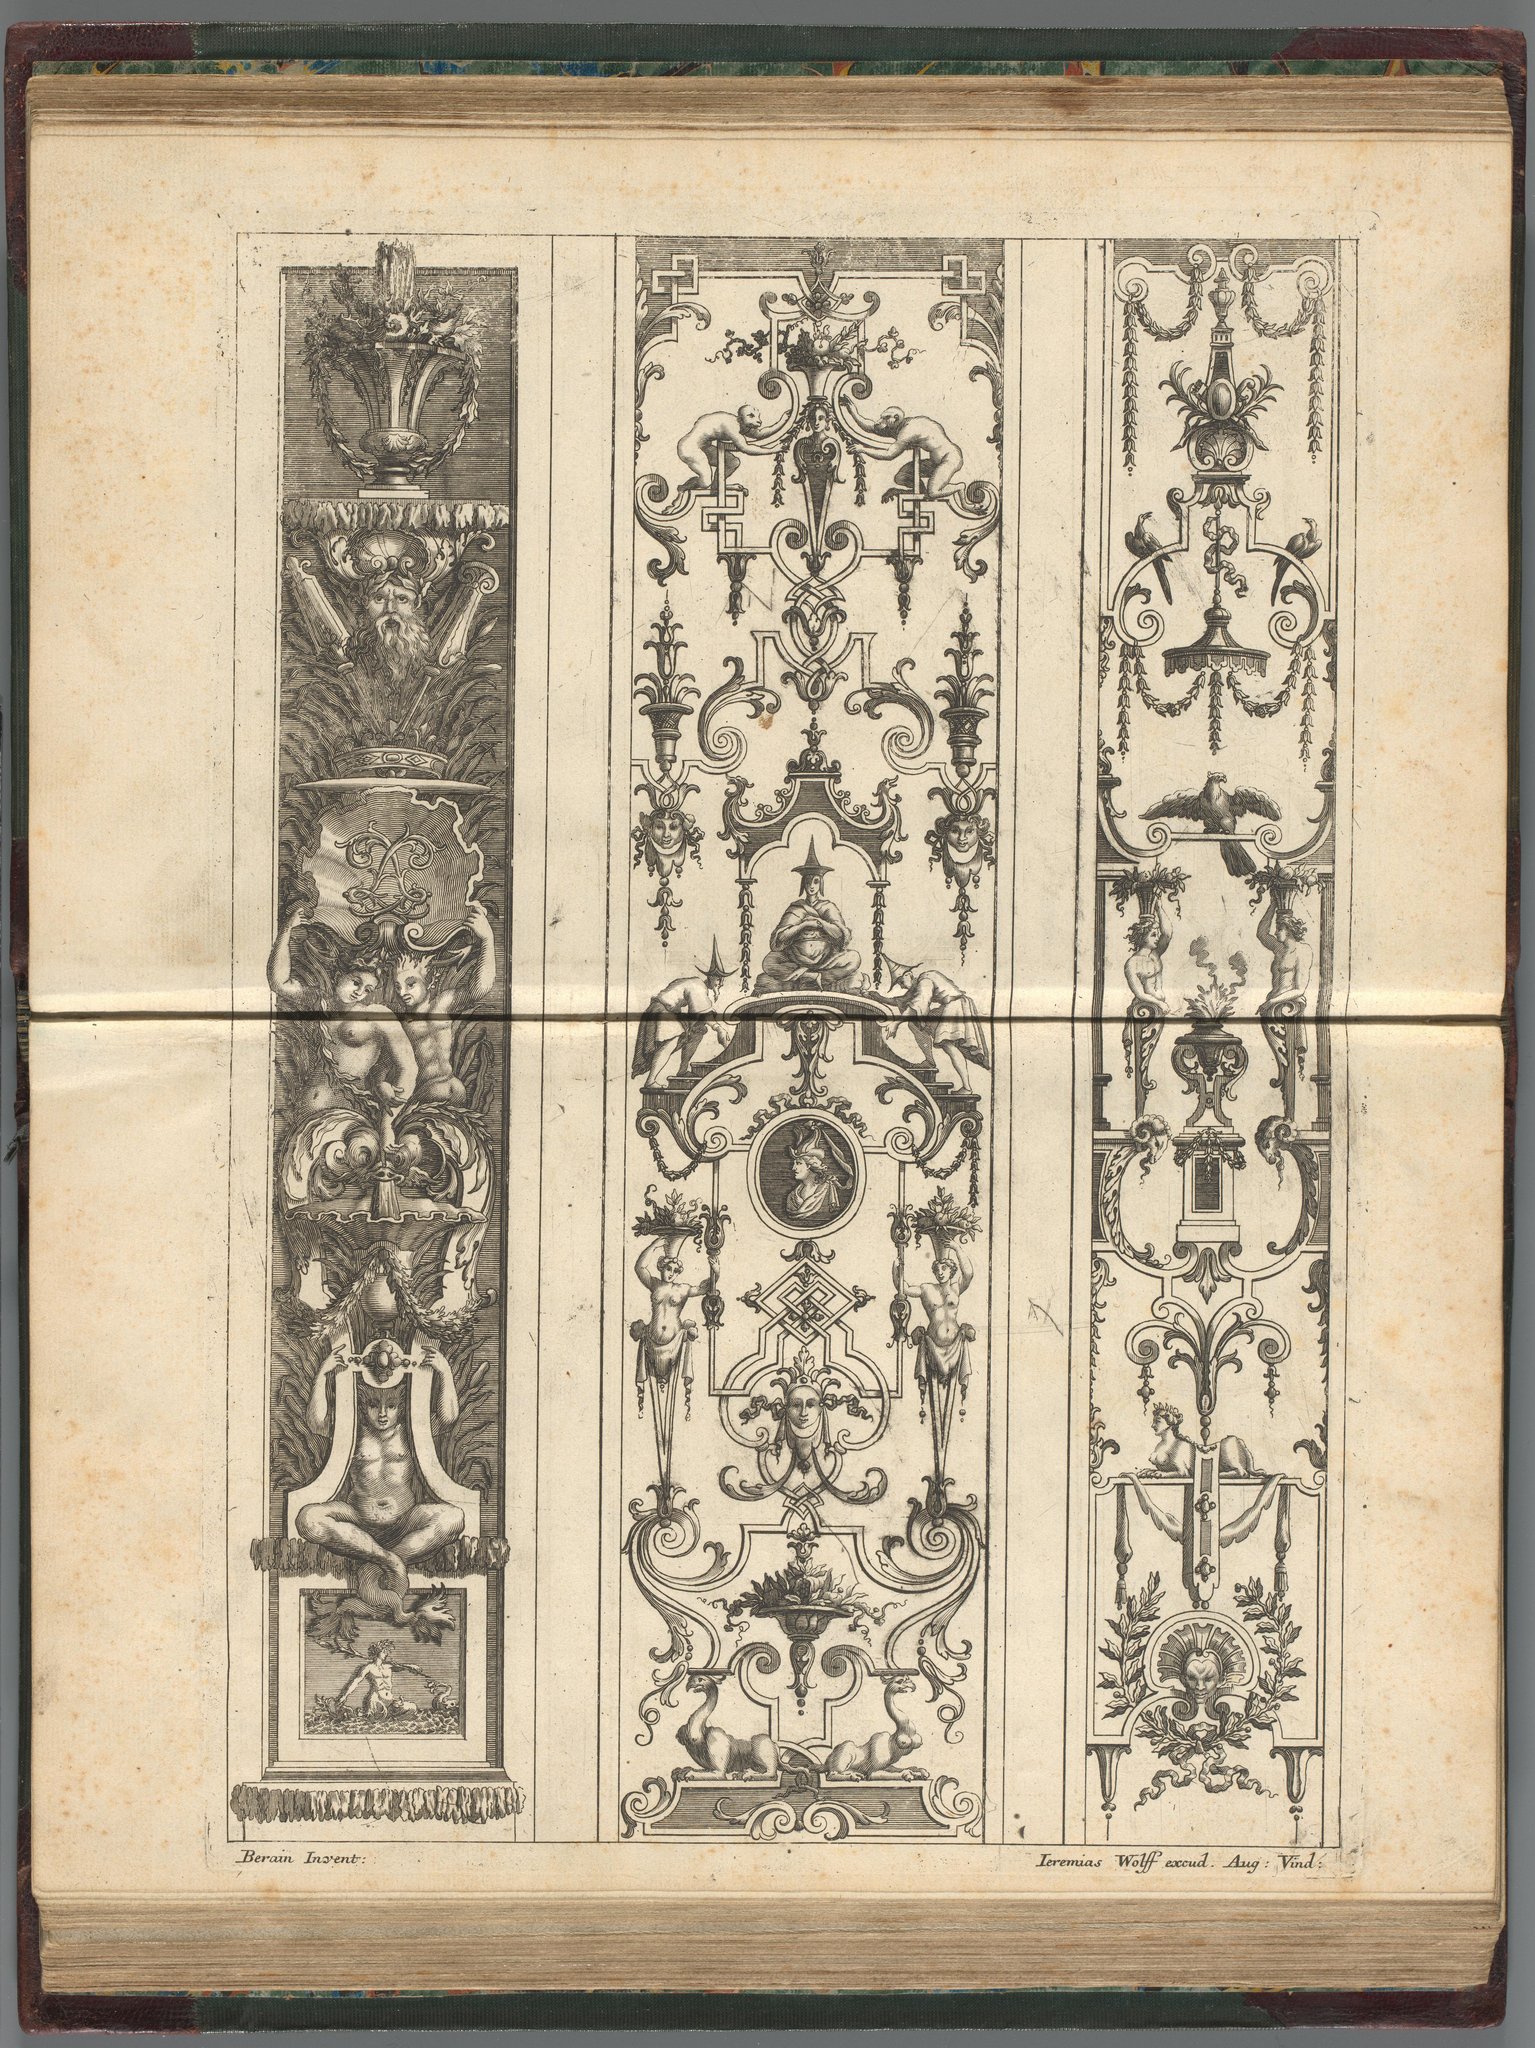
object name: album leaf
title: Compositie met Aziatische figuren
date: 1686-1724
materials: paper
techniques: etching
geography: augsburg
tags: asiatic races and peoples, ornaments ~ art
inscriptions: signature: ‘Ieremias Wolff excud. Aug. Vind.’, signature: ‘Berain Invent.’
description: Een decoratieve compositie bestaand uit drie panelen met vlechtwerk. Links een fontein in de vorm van een vaas gedragen door een bebaarde kop met roeispanen. Daaronder dragen twee halffiguren een schelp met initialen van Lodewijk XIV. Aan de onderzijde een tablet met een meerman op een dolfijn. In het midden wordt een Aziatische man aanbeden door twee Aziatische figuren. Aan de bovenzijde zitten twee apen. Aan de onderzijde een medaillon met portret en twee kariatiden. Rechts vogels, kariatiden, een rookvat en een sfinx. Prent maakt deel uit van een album. Hoogstwaarschijnlijk gespiegelde kopie naar Frans origineel.